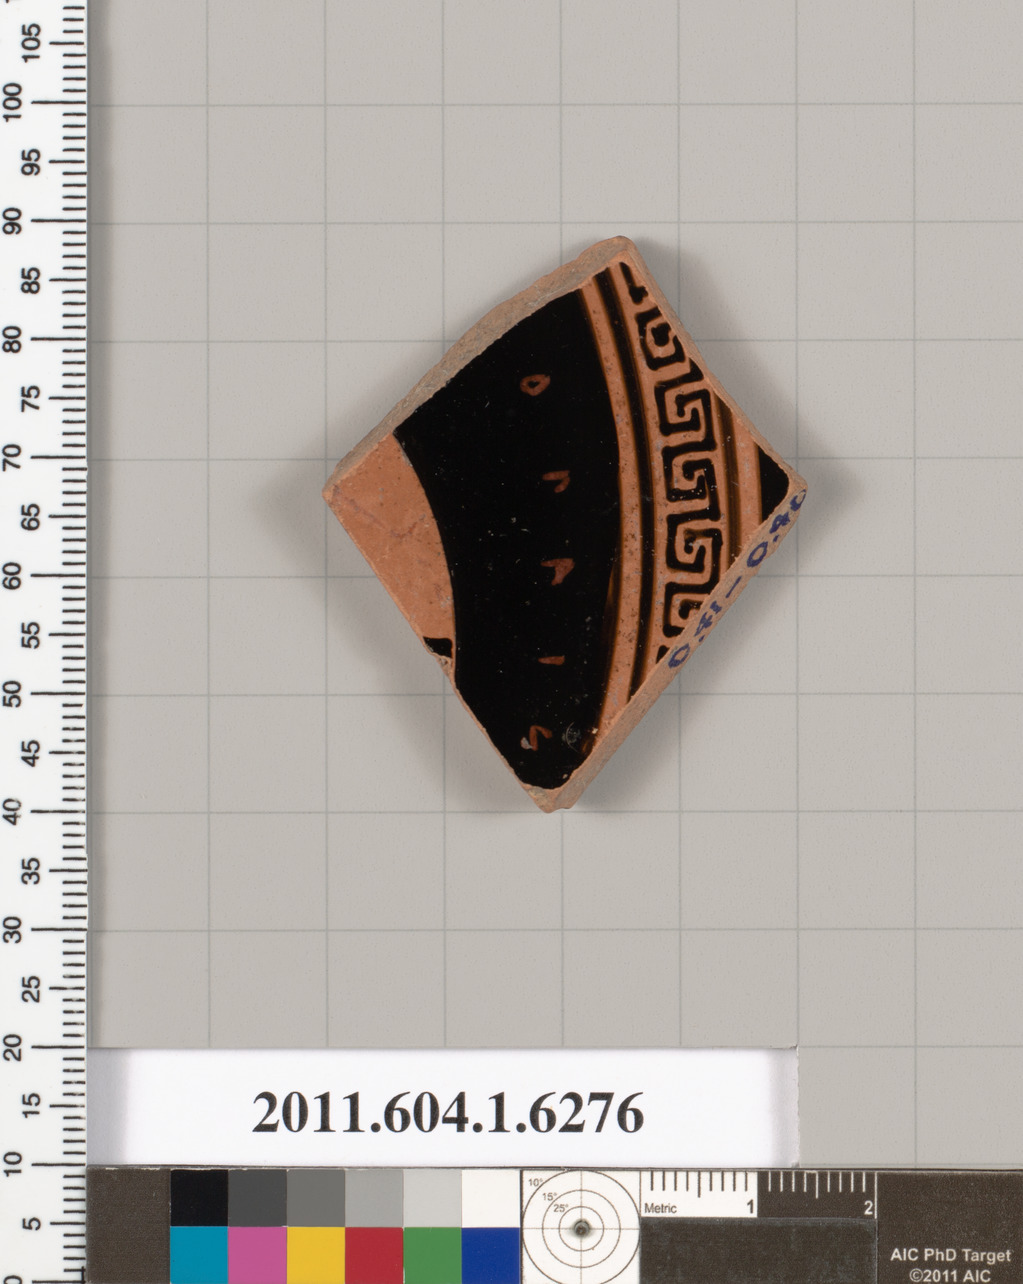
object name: kylix fragment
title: Terracotta fragment of a kylix (drinking cup)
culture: greek, attic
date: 500-480 BCE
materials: terracotta